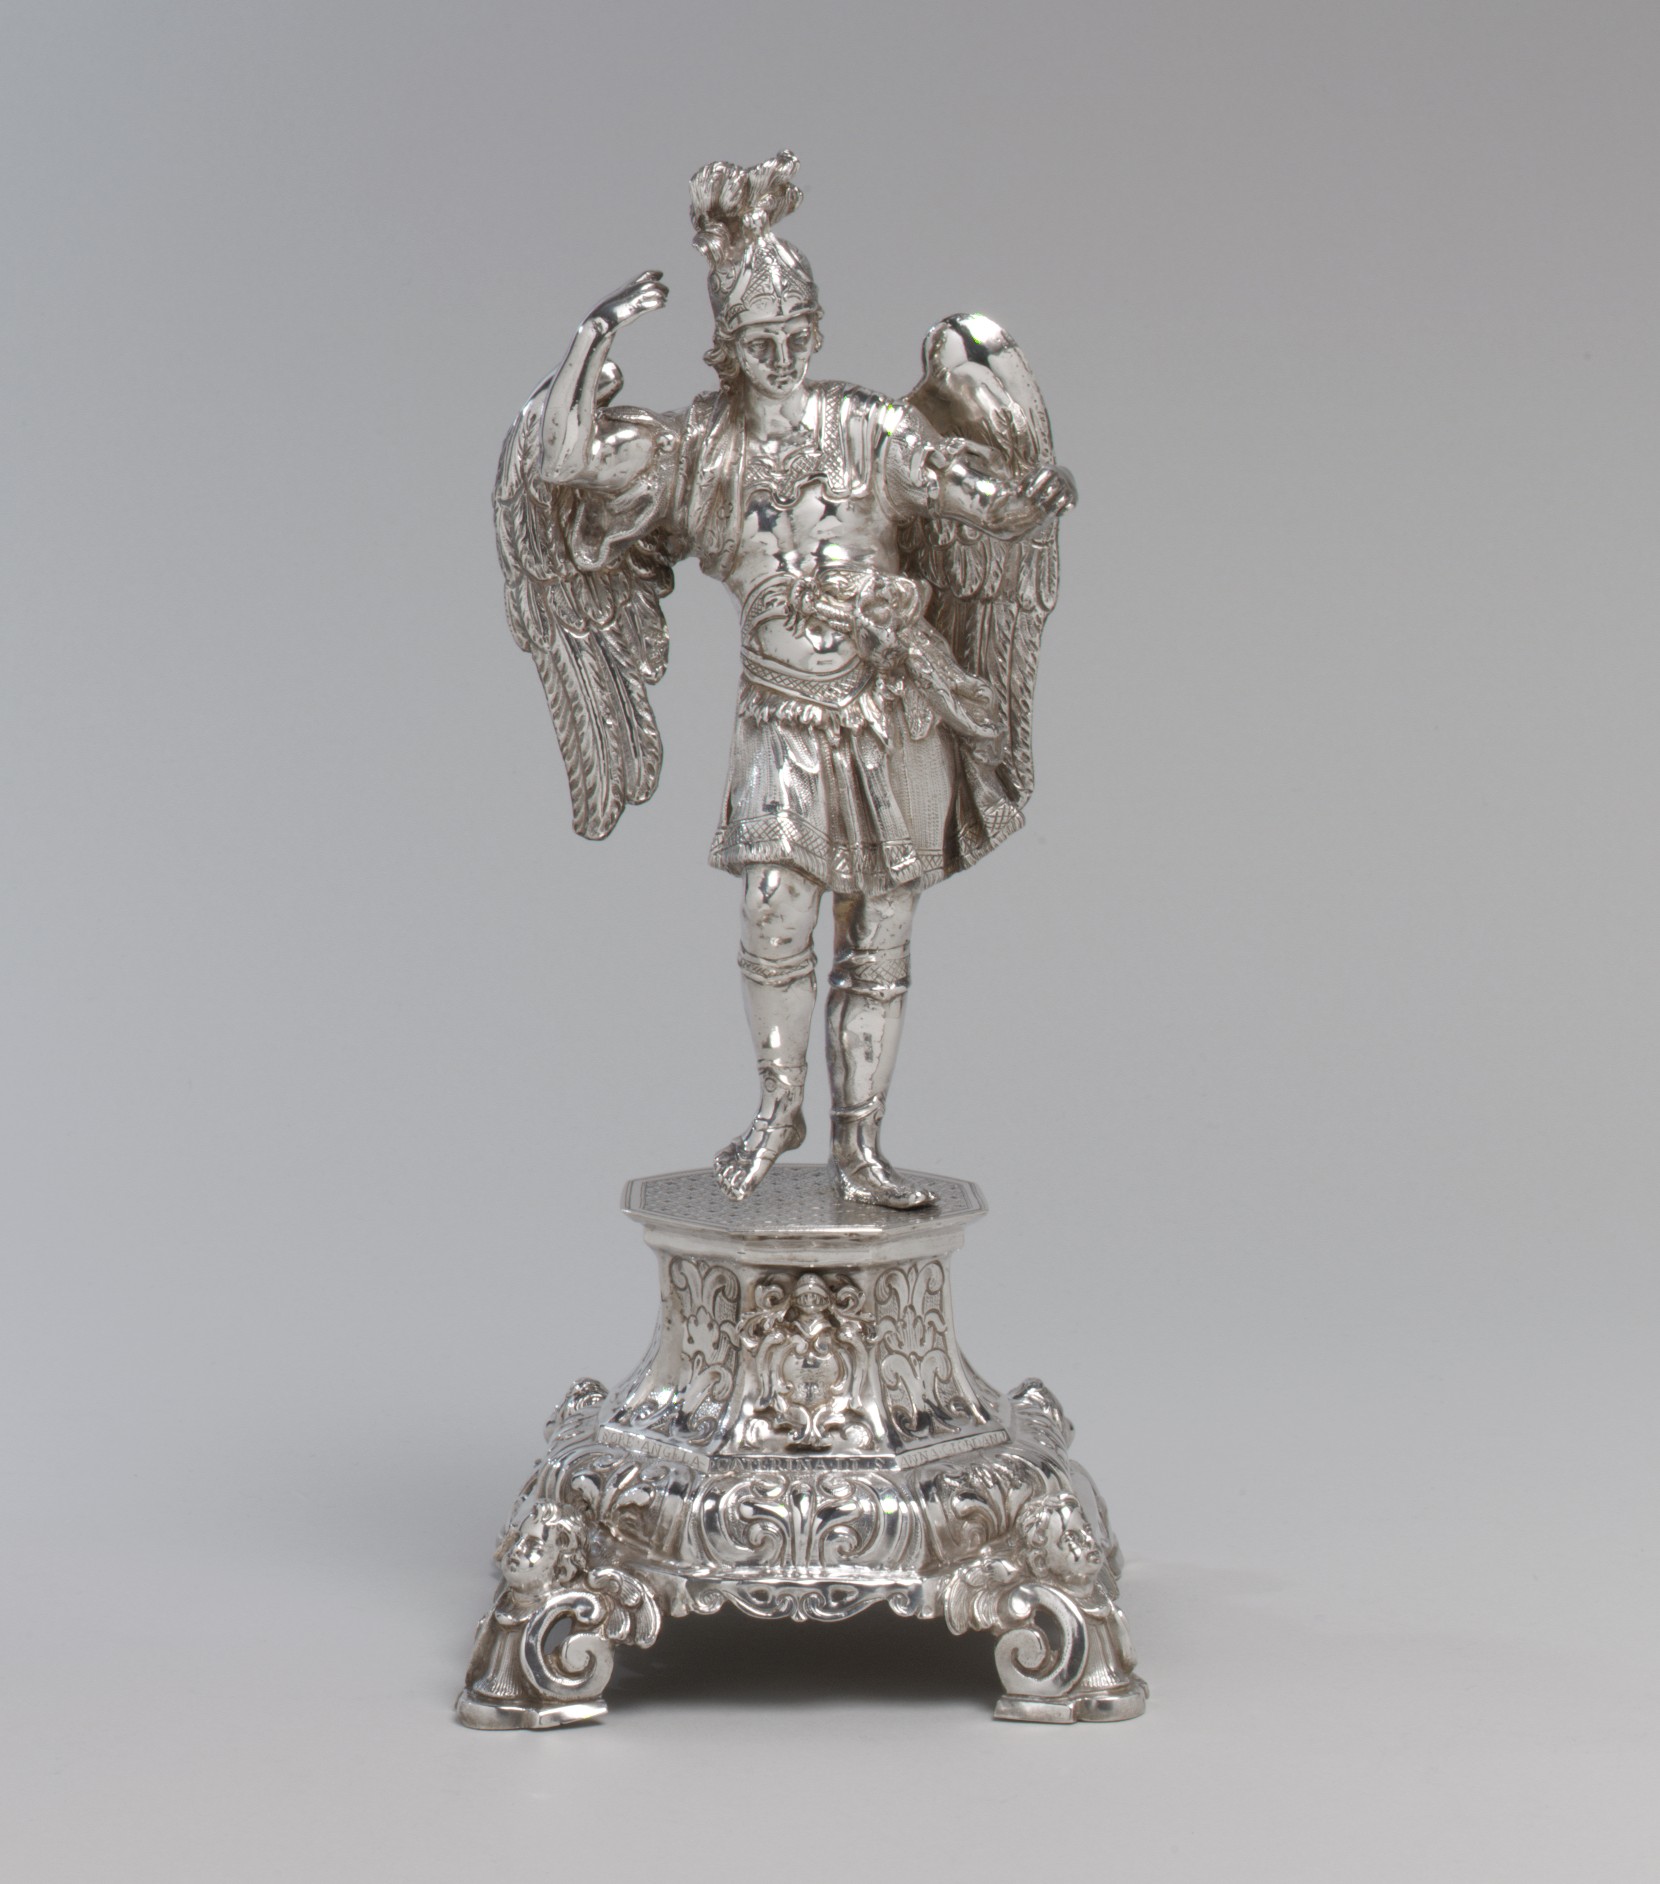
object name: statuette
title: Saint Michael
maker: gaetano fumo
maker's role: artist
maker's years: 1737-1759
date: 1740-1745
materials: silver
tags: men,saint michael